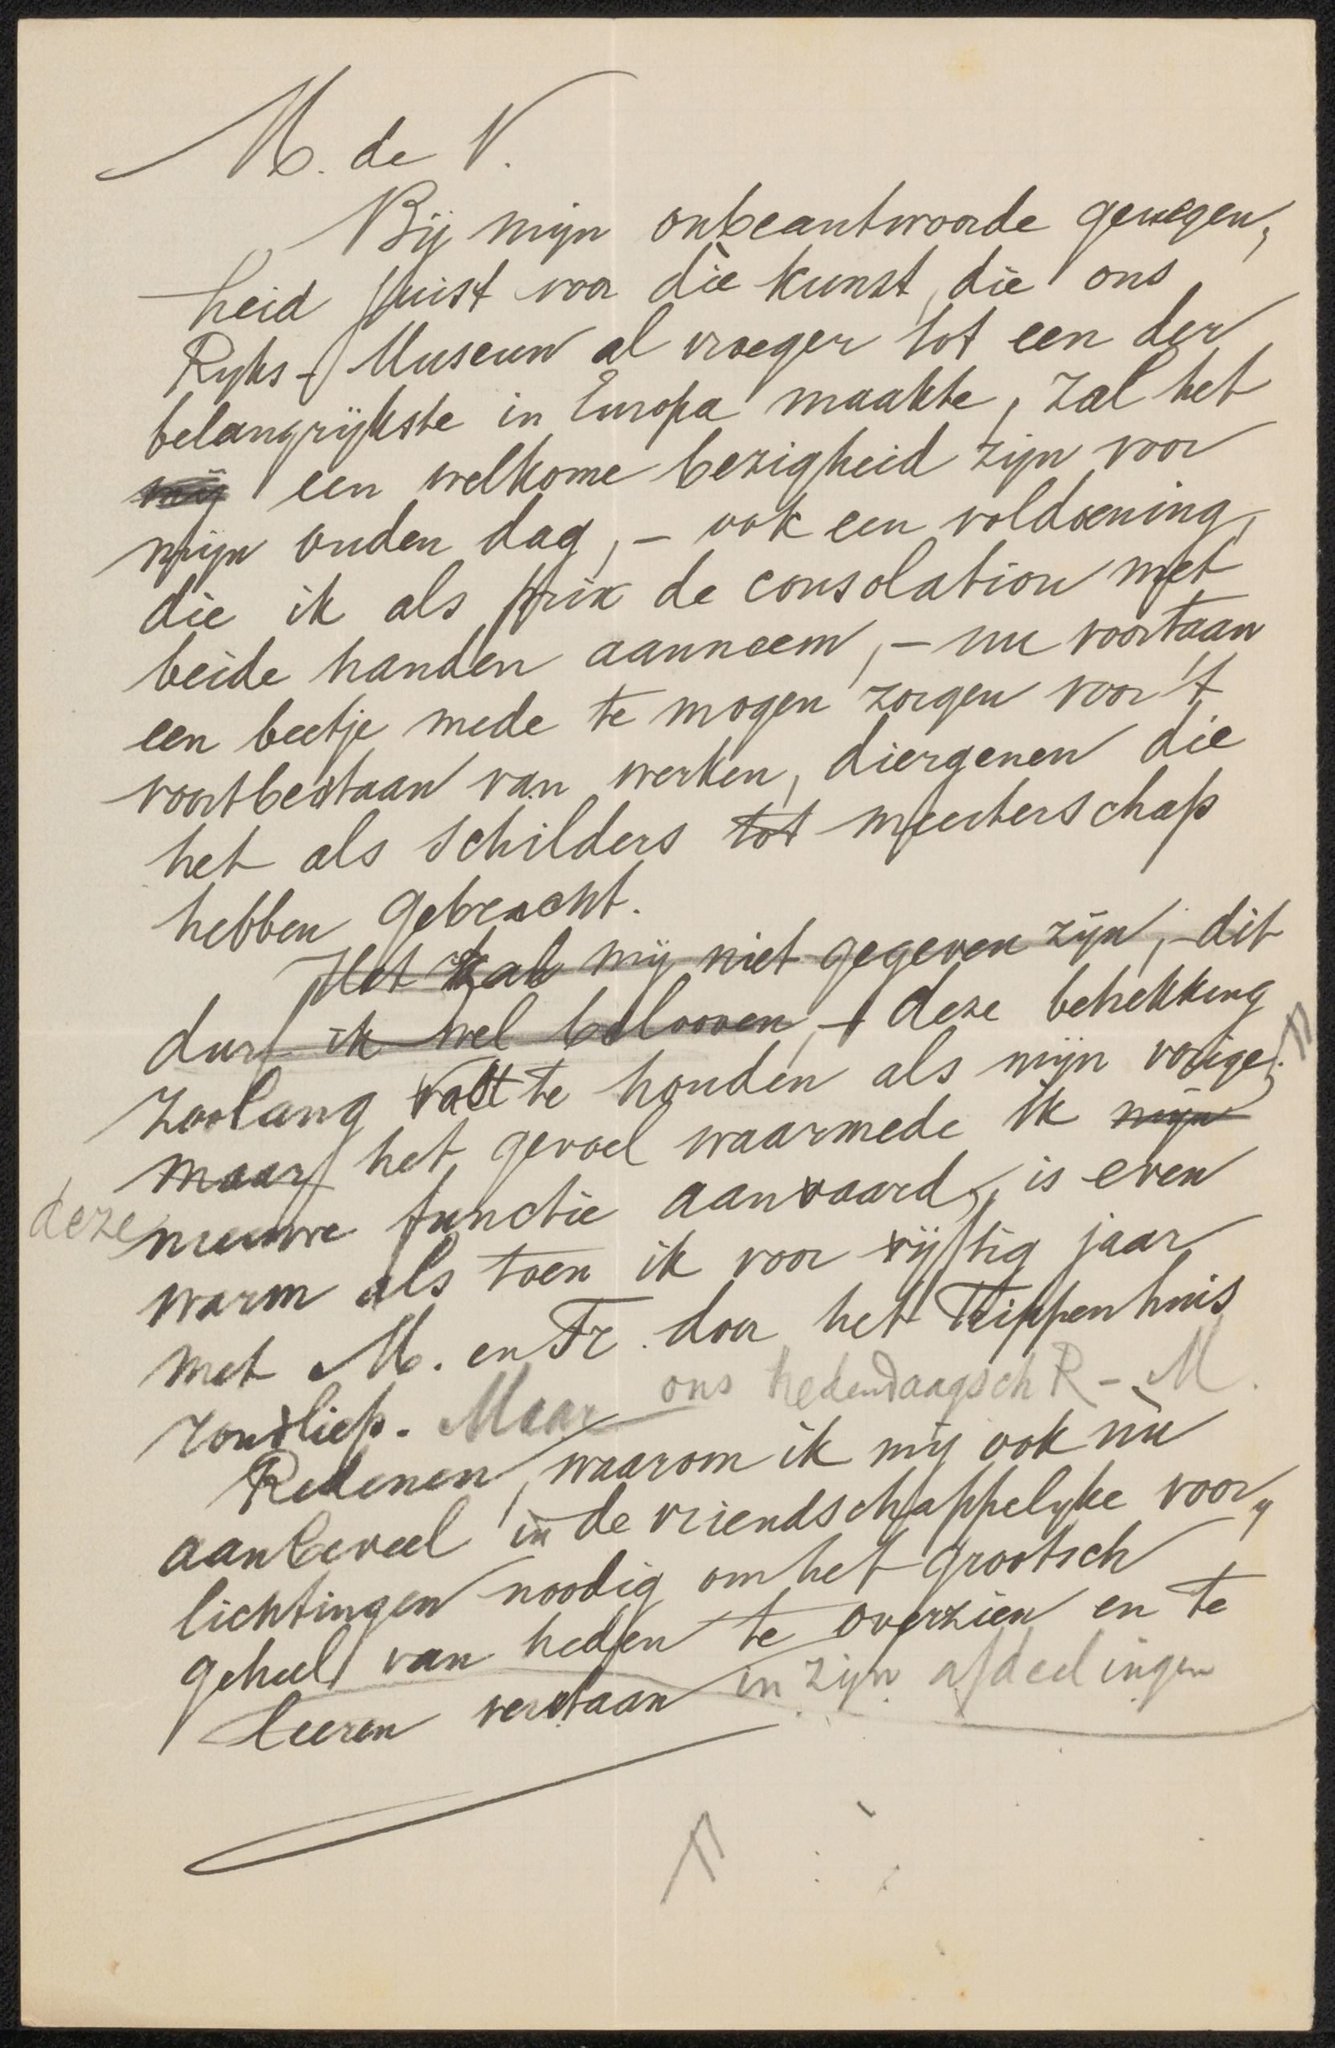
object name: letter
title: Conceptbrief aan onbekend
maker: august allebé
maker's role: draughtsman, print maker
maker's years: 1838-1927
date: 1848-1927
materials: ink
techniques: pen, writing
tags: rijksmuseum amsterdam